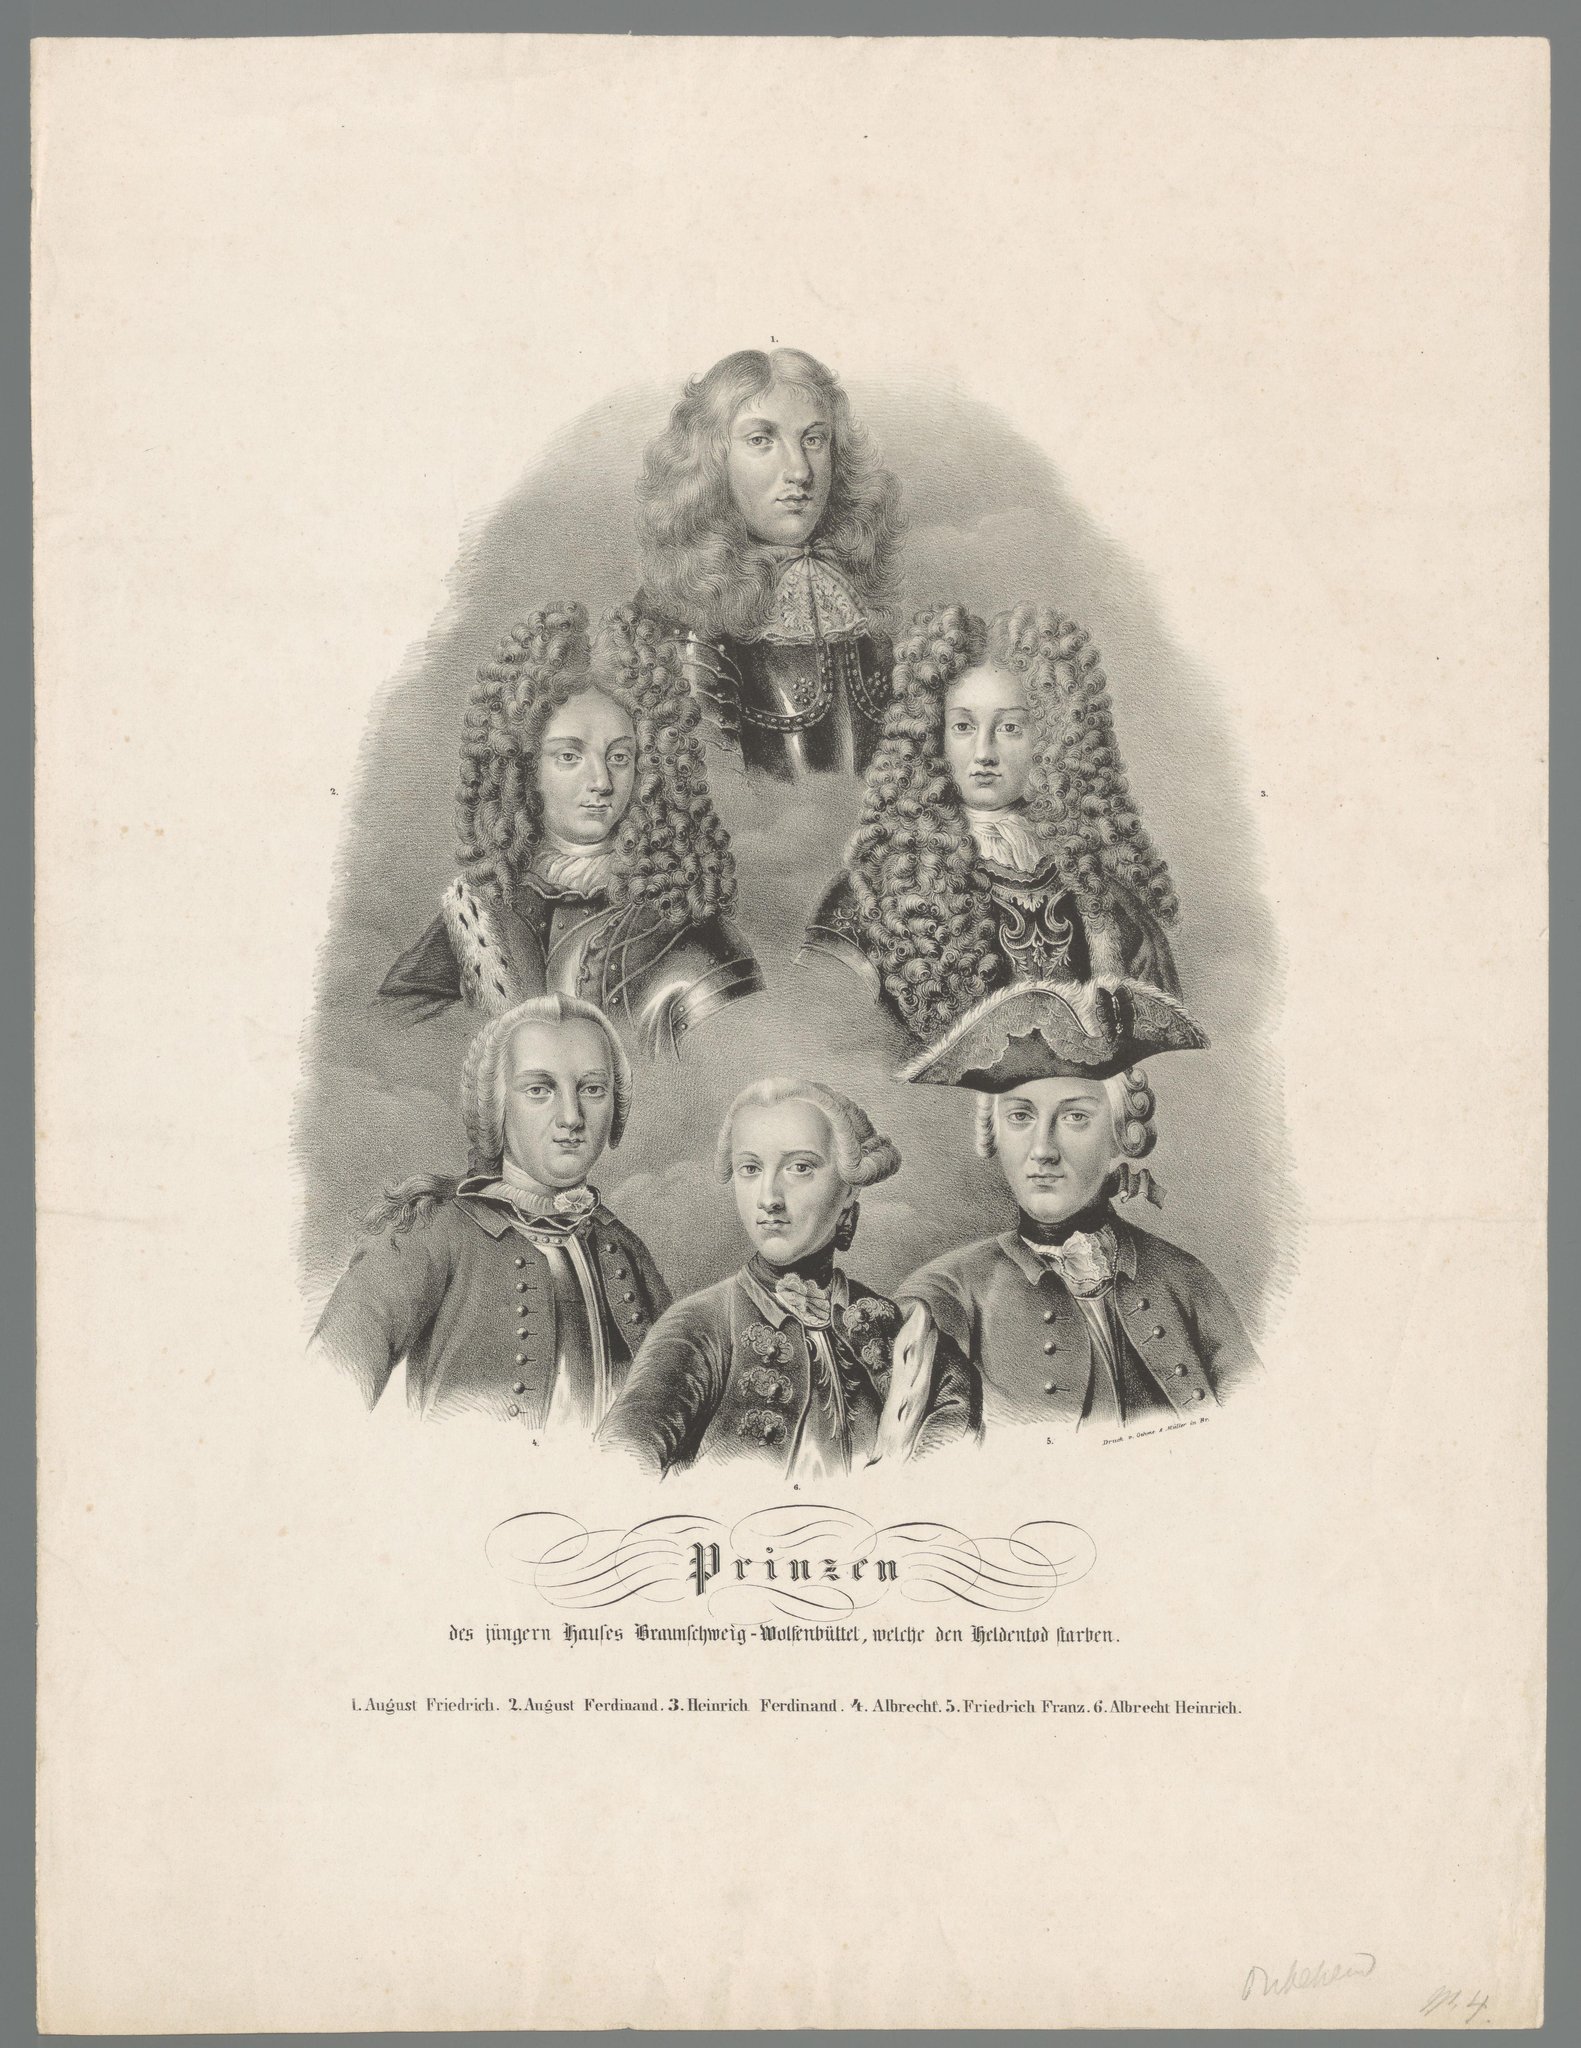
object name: print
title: Prinzen, des jüngern Hauses Braunschweig-Wolfenbüttel, welche den Heldentod starben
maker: Anonymous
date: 1820-1860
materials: paper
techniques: lithograph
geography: braunschweig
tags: historical persons, youth, adolescent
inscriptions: collector's mark: Lugt 2228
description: Portretten van August Friedrich, August Ferdinand, Heinrich Ferdinand, Albrecht, Friedrich Franz en Albrecht Heinrich.